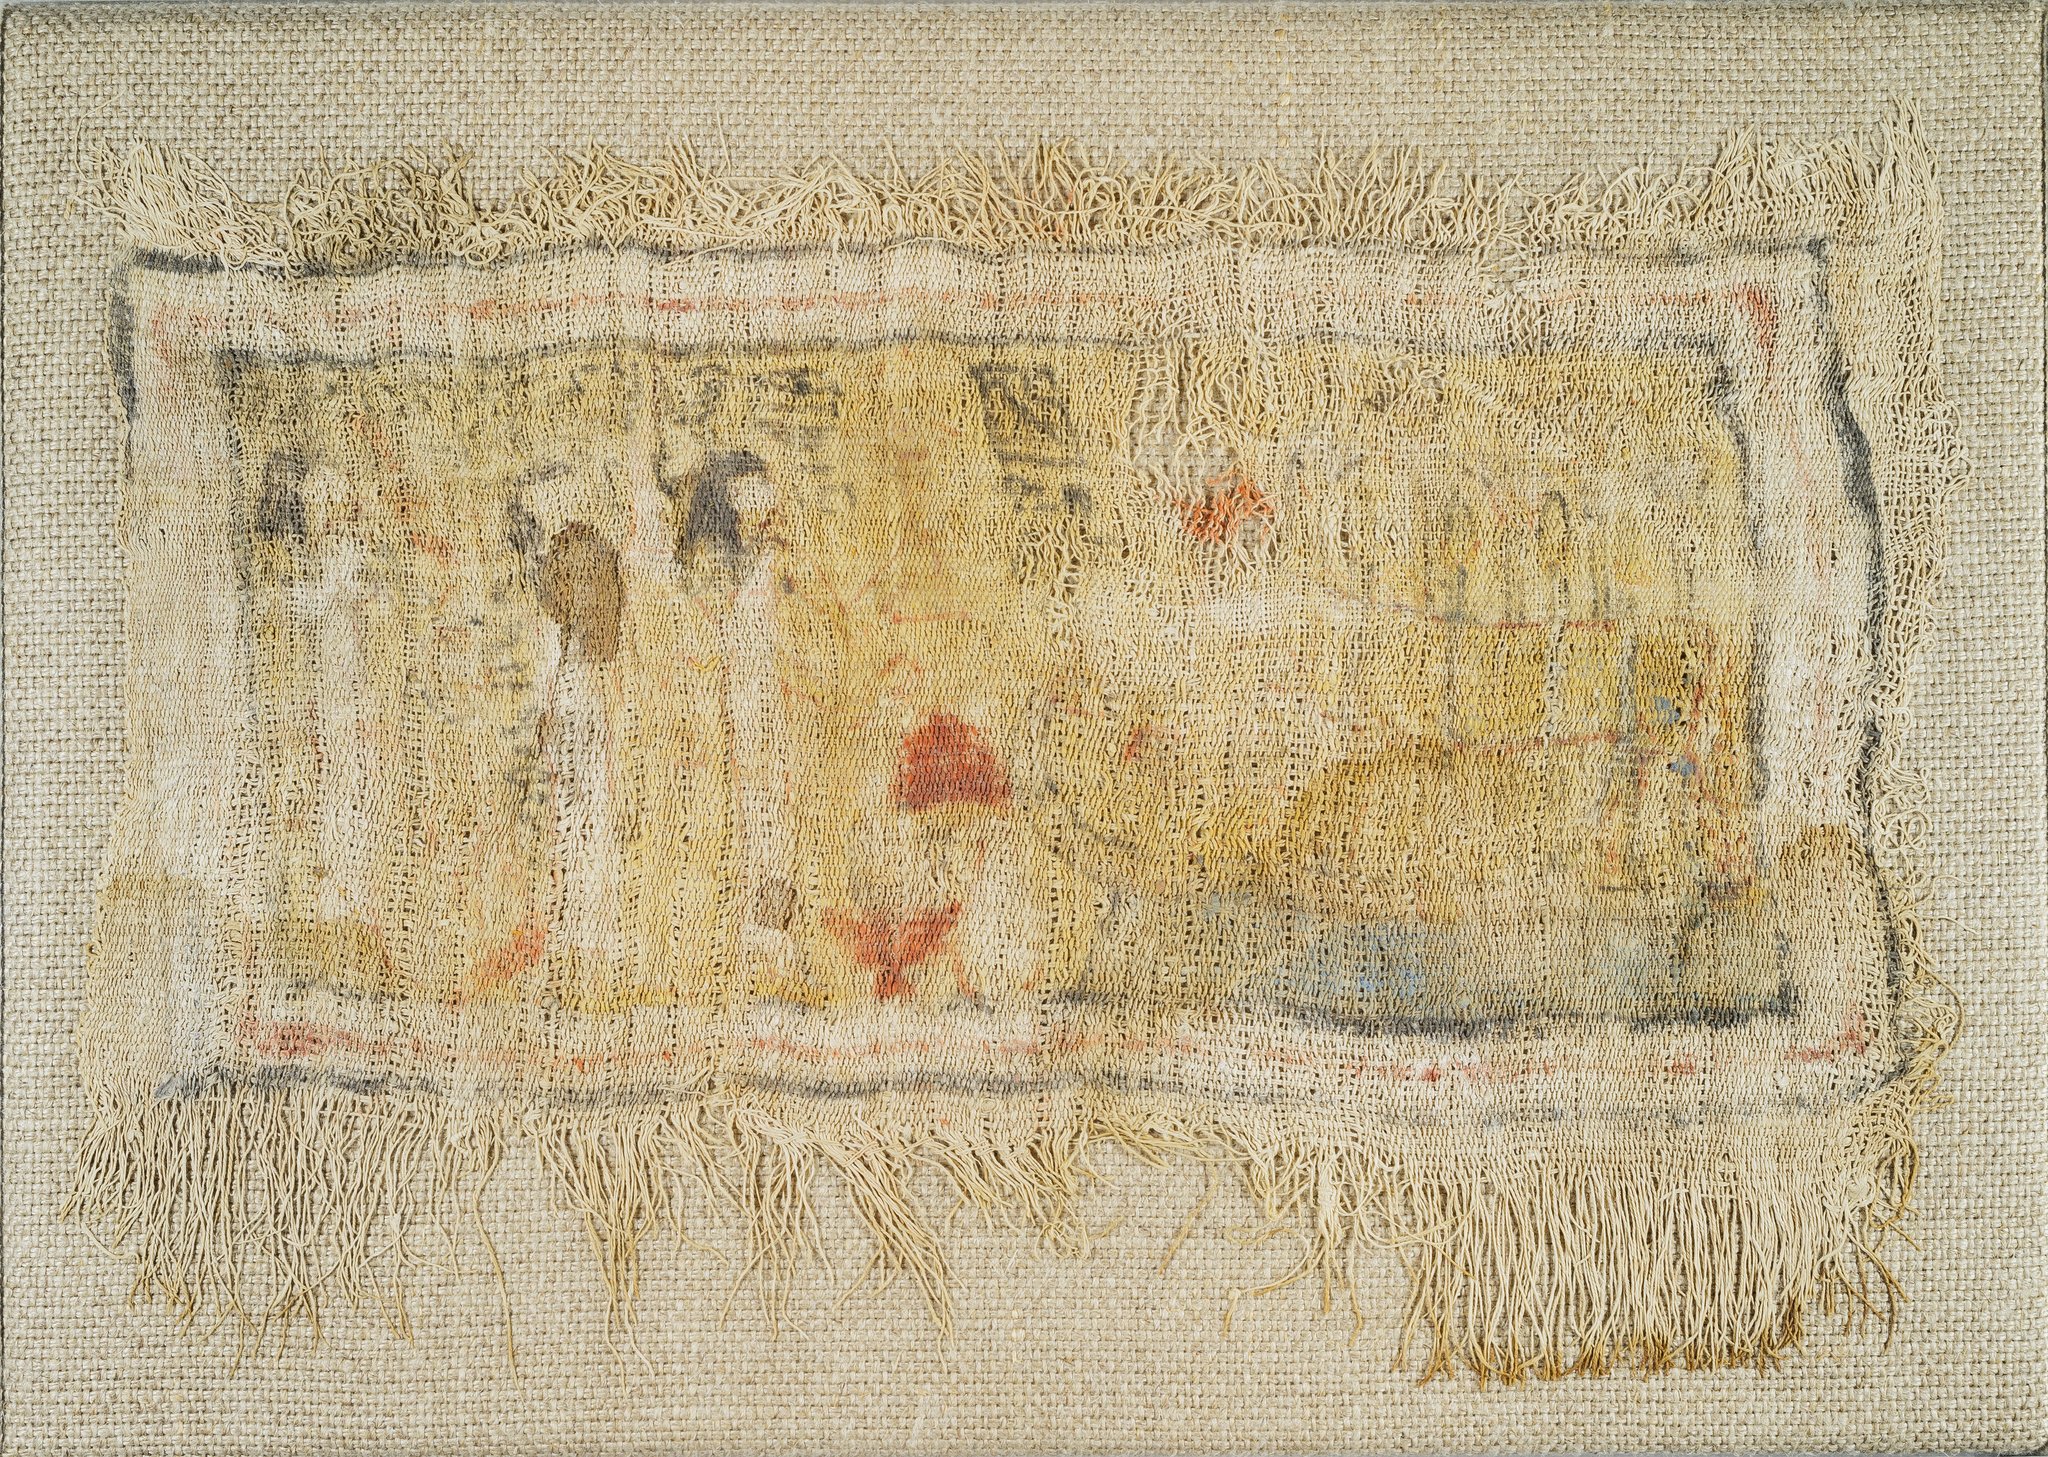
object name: linen, cloth, votive, hathor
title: Painted Cloth Dedicated to Hathor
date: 1479-1458 BCE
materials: linen, paint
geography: egypt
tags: human figures